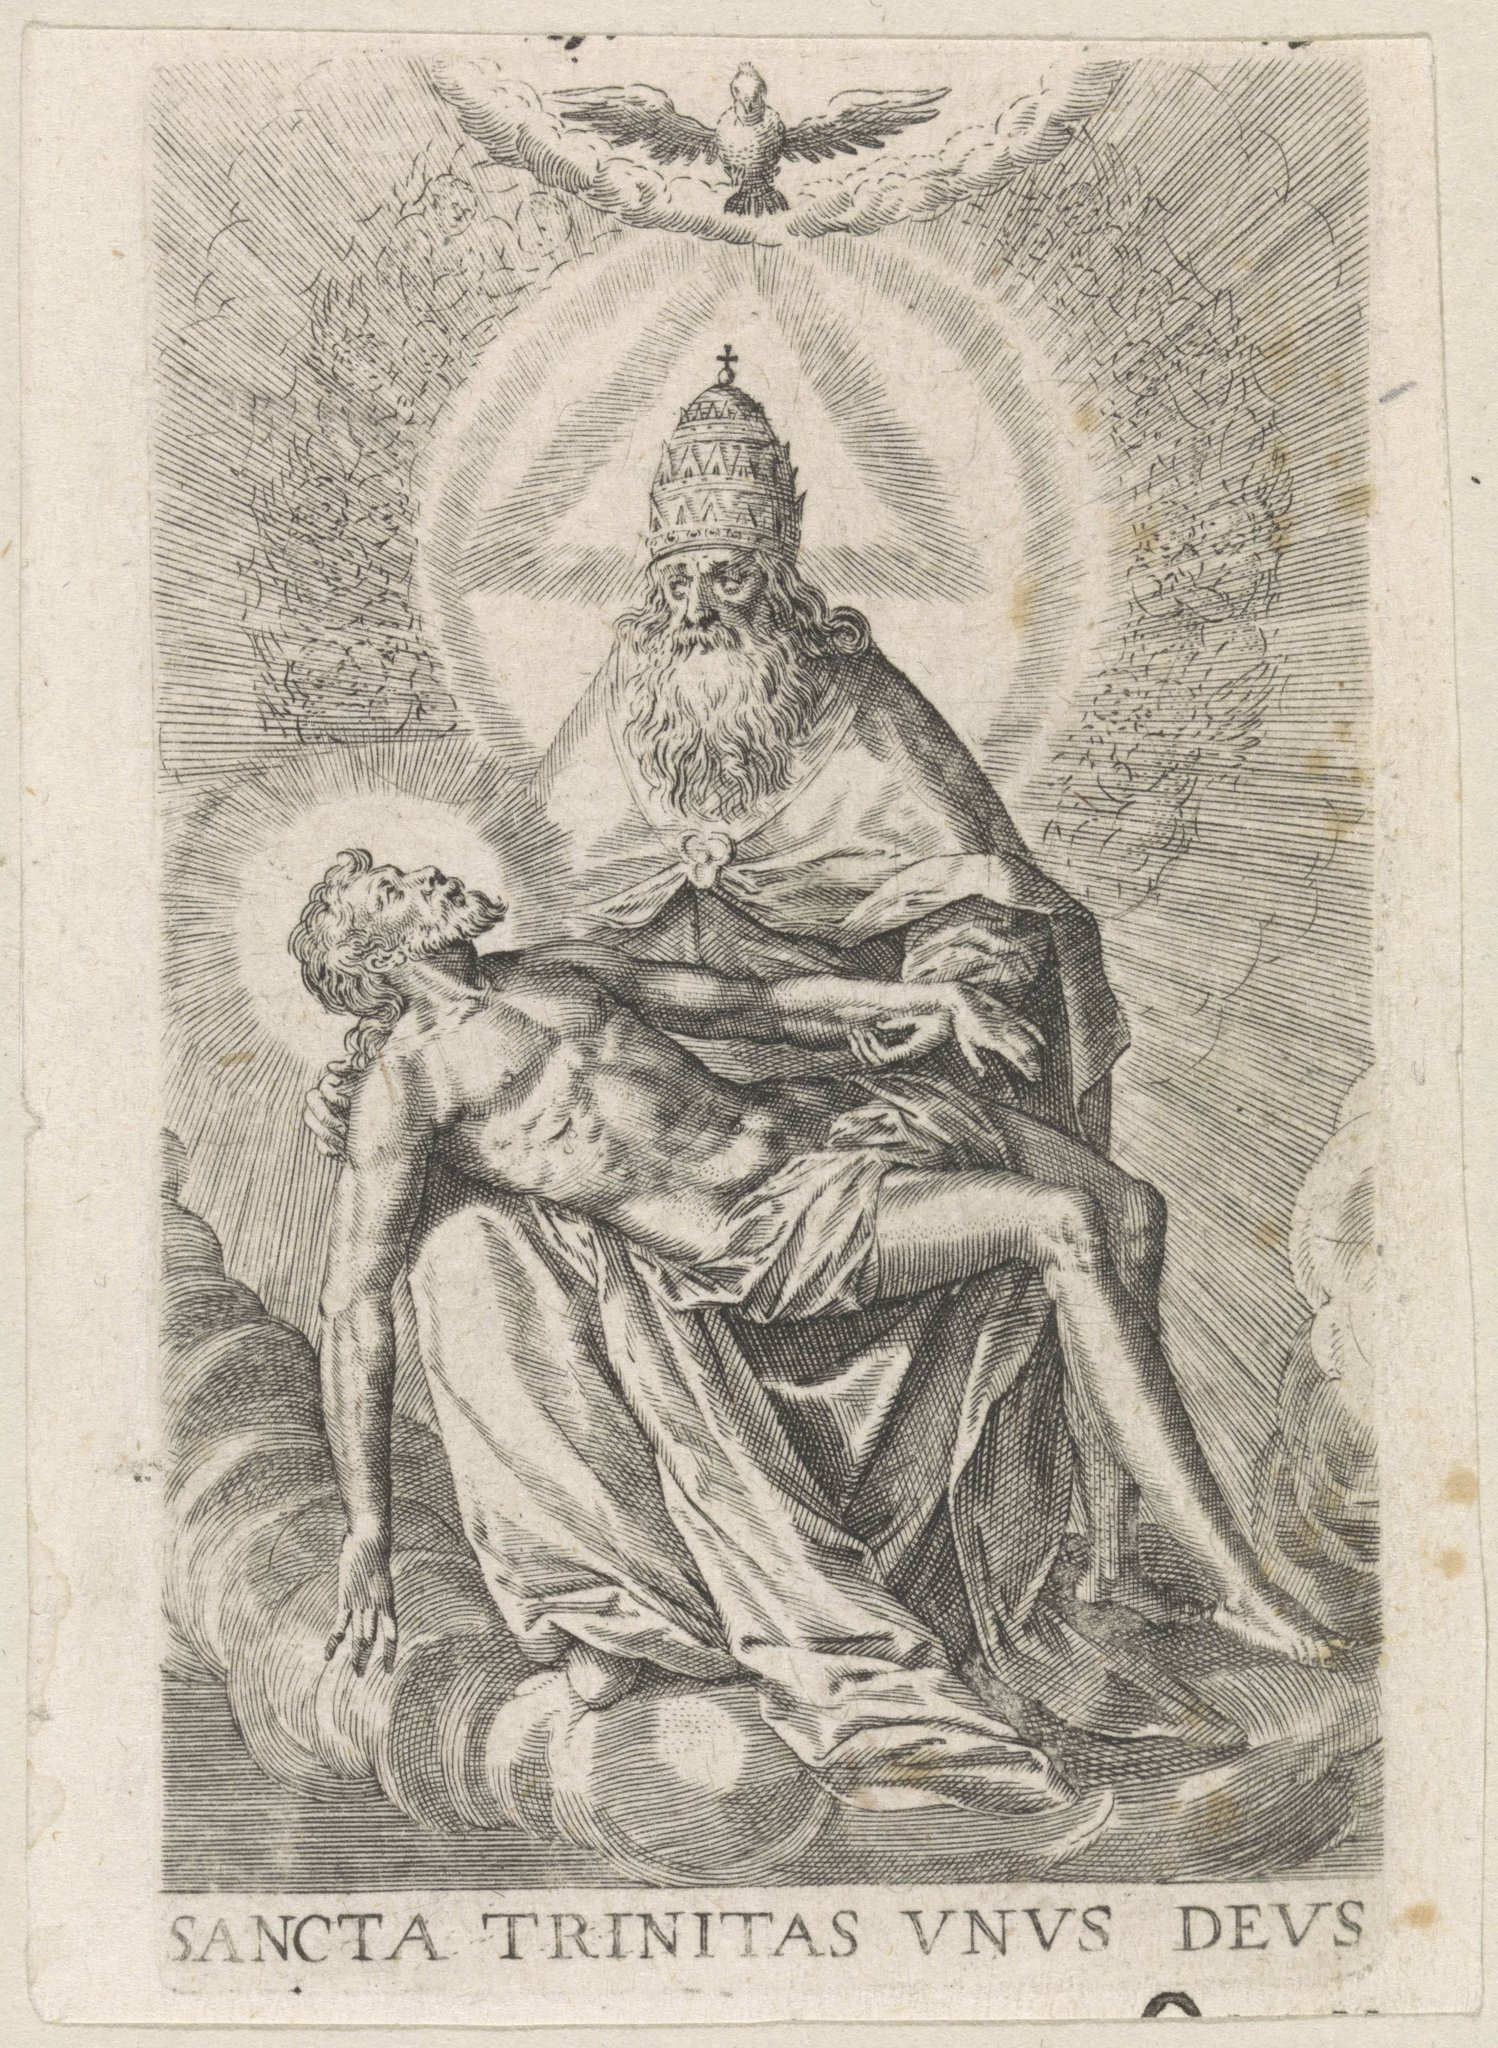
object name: print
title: Sancta trinitas vnvs Devs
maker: anna bergia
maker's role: publisher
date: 1617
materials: paper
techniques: engraving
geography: munich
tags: father and holy ghost holding the crucified christ (~ trinity)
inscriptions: collector's mark: Lugt 240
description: Prent uit: Ceschi, Matia. Otium spirituale mellifluarum precationum. München: Anna Bergia en Raphaël Sadeler (I) of (II), 1617.